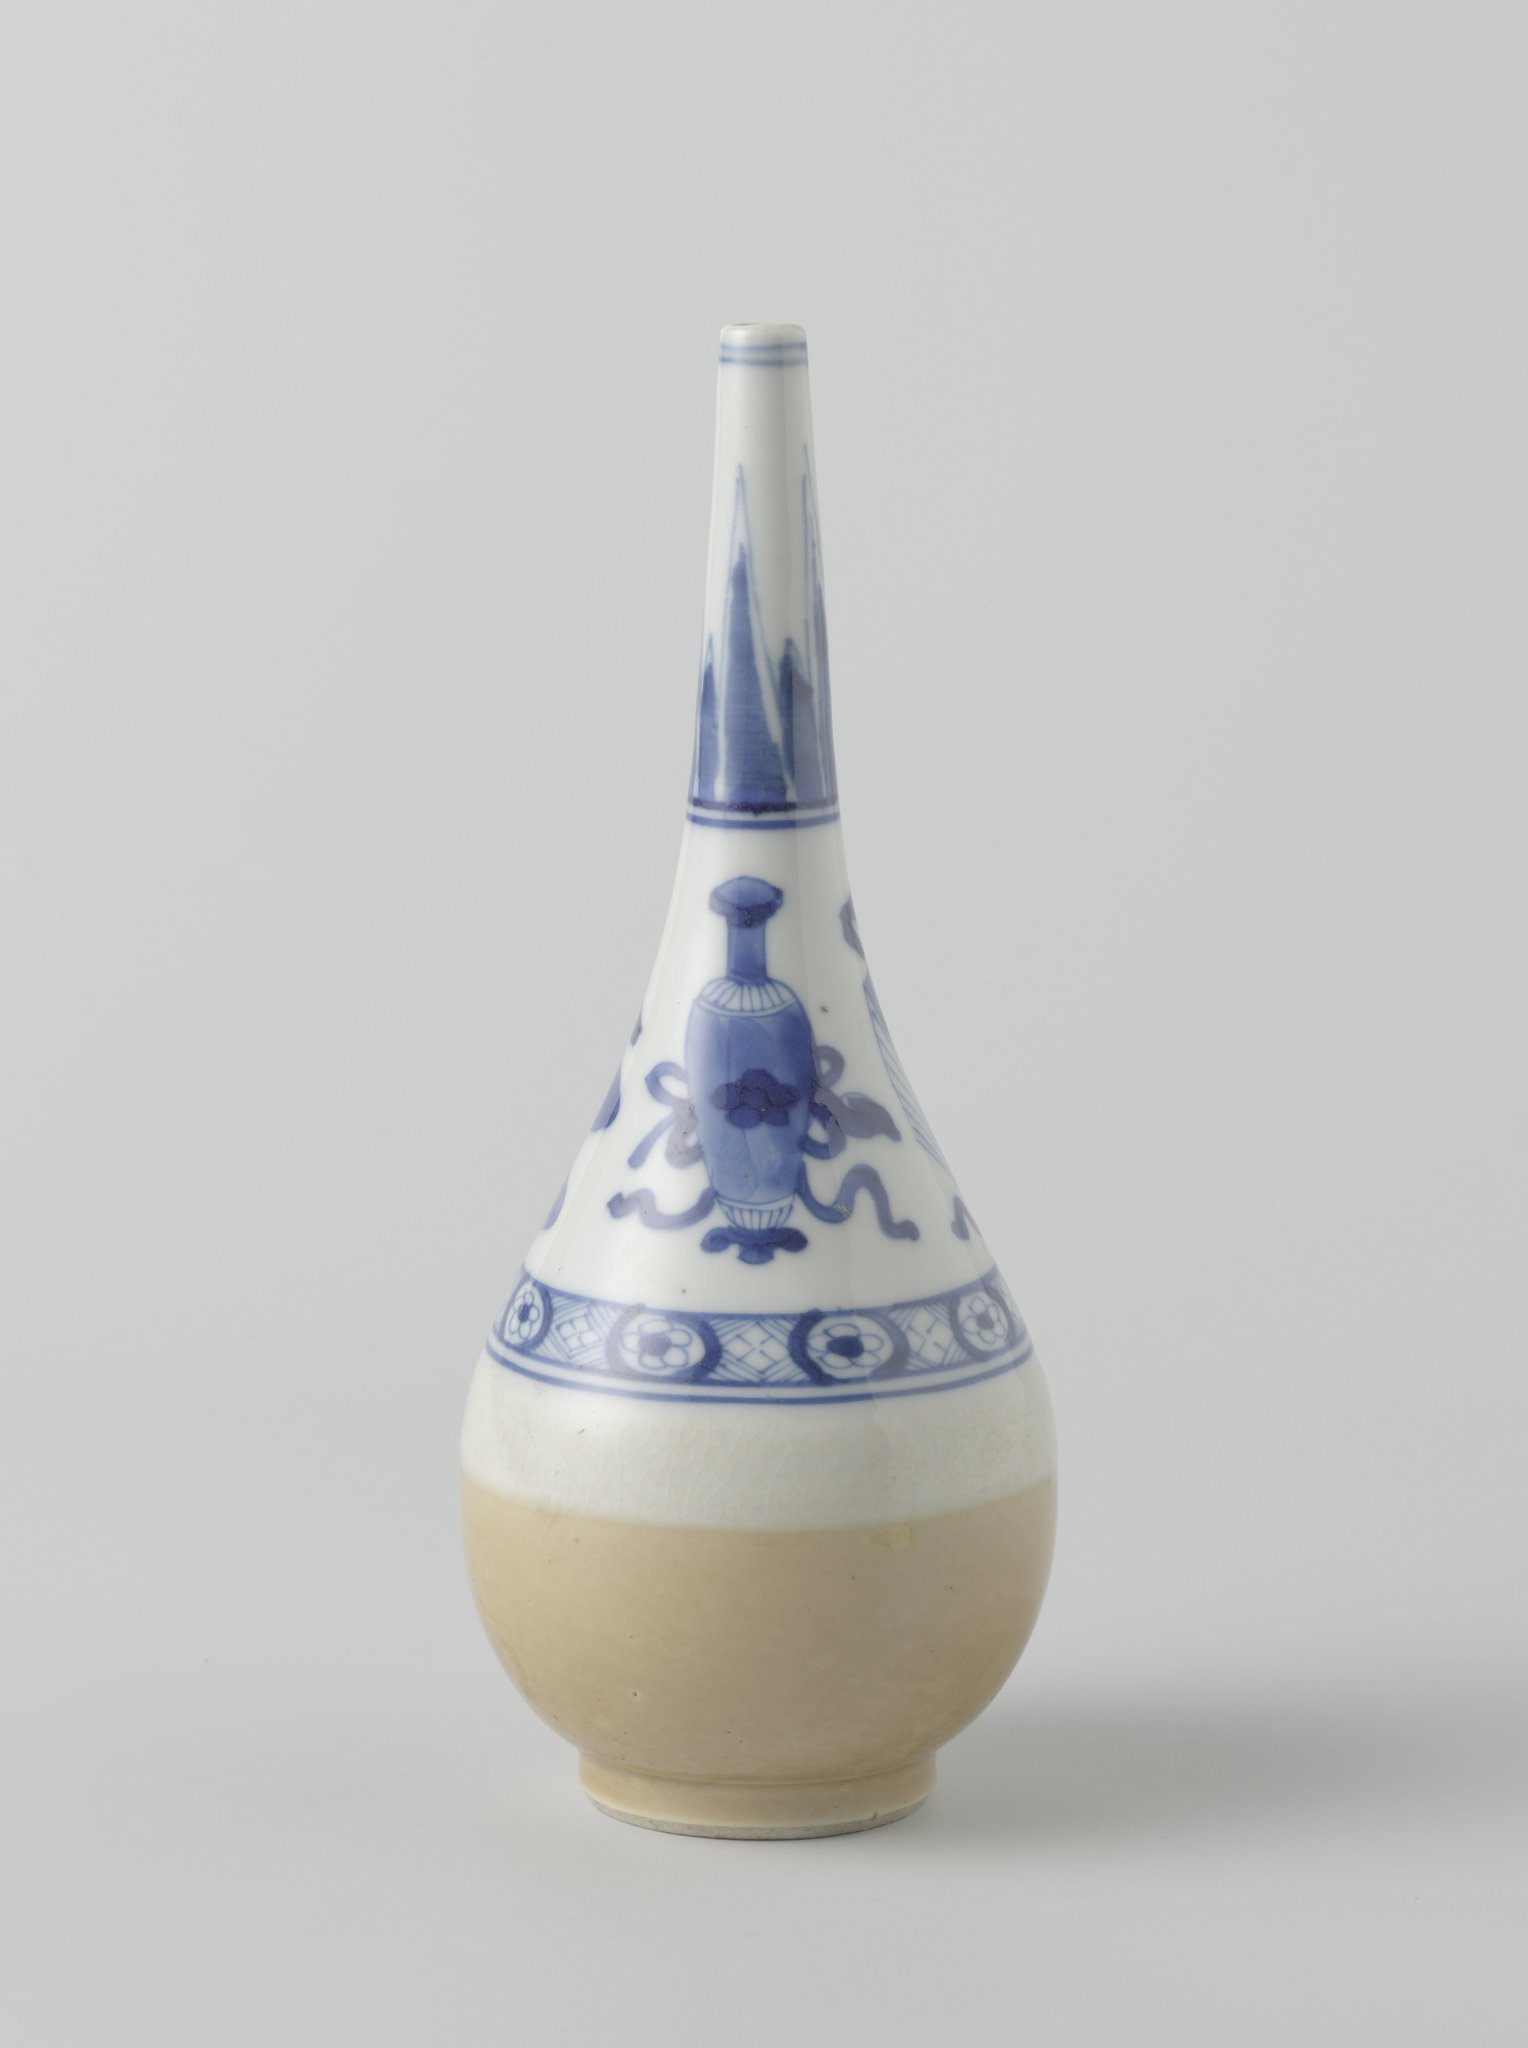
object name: sprinkler flask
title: Bottle vase with light brown and precious object and antiquities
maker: Anonymous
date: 1700-1724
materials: cobalt, glaze, paint, porcelain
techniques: firing, turning, vitrification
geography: china